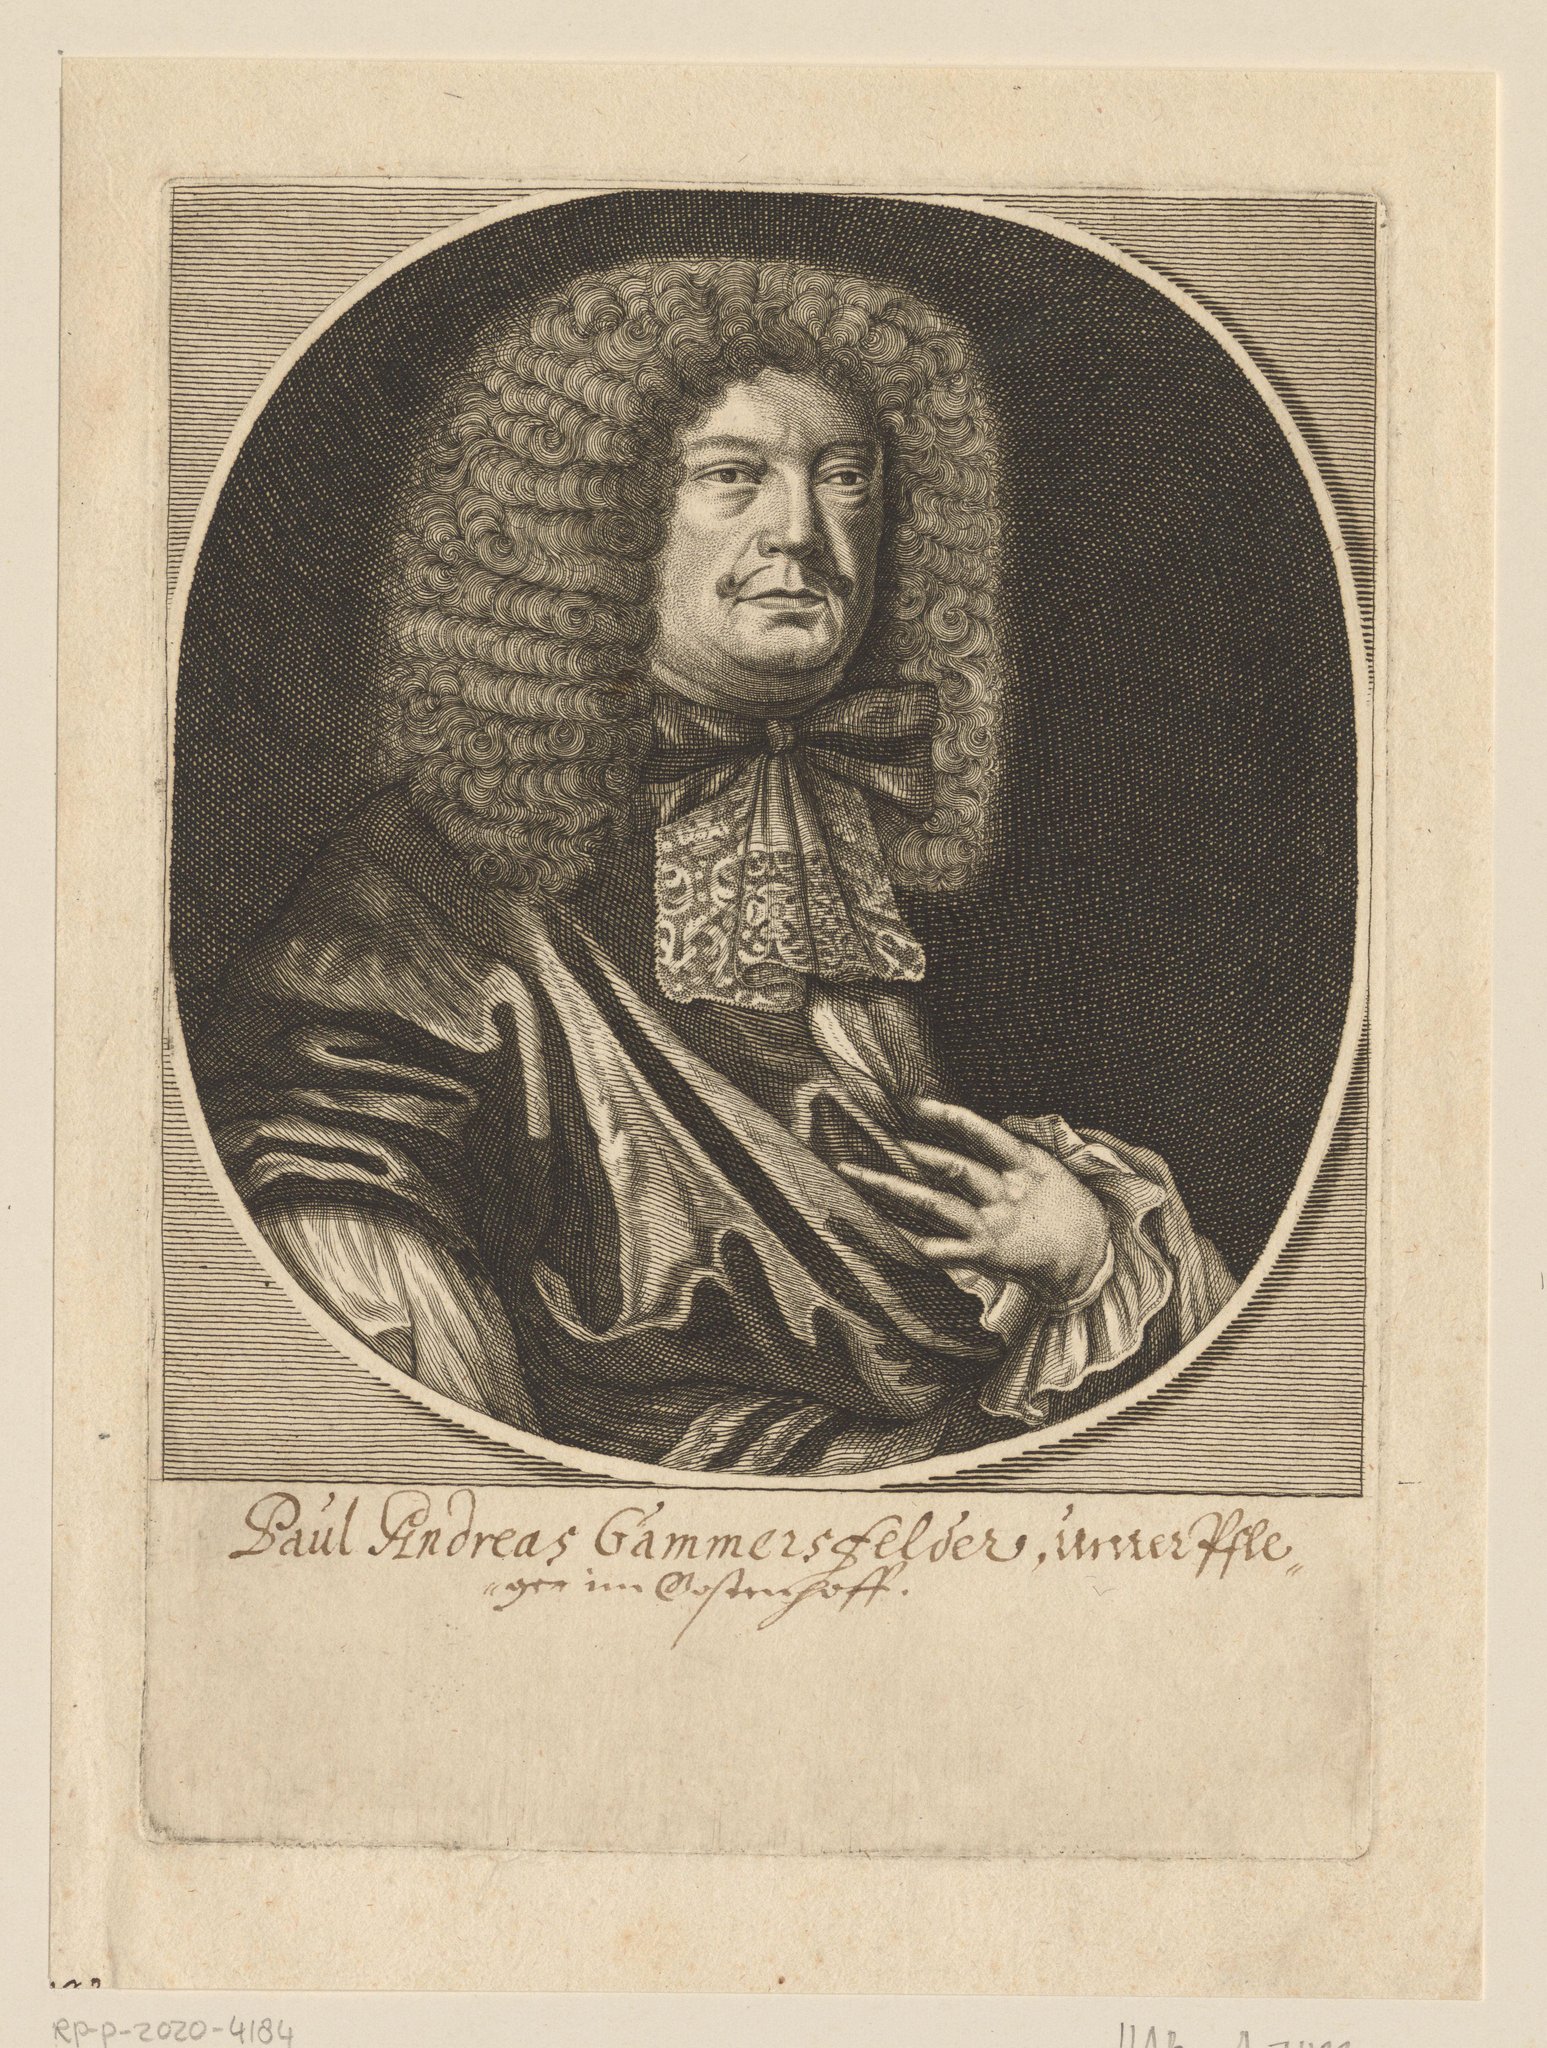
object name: print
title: Portret van Andreas Paul Gammersfelder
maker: Anonymous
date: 1650-1750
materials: paper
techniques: engraving, etching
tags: politician, historical persons, commander-in-chief, admiral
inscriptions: : ‘Paul Andreas Gammersfelder [...]’